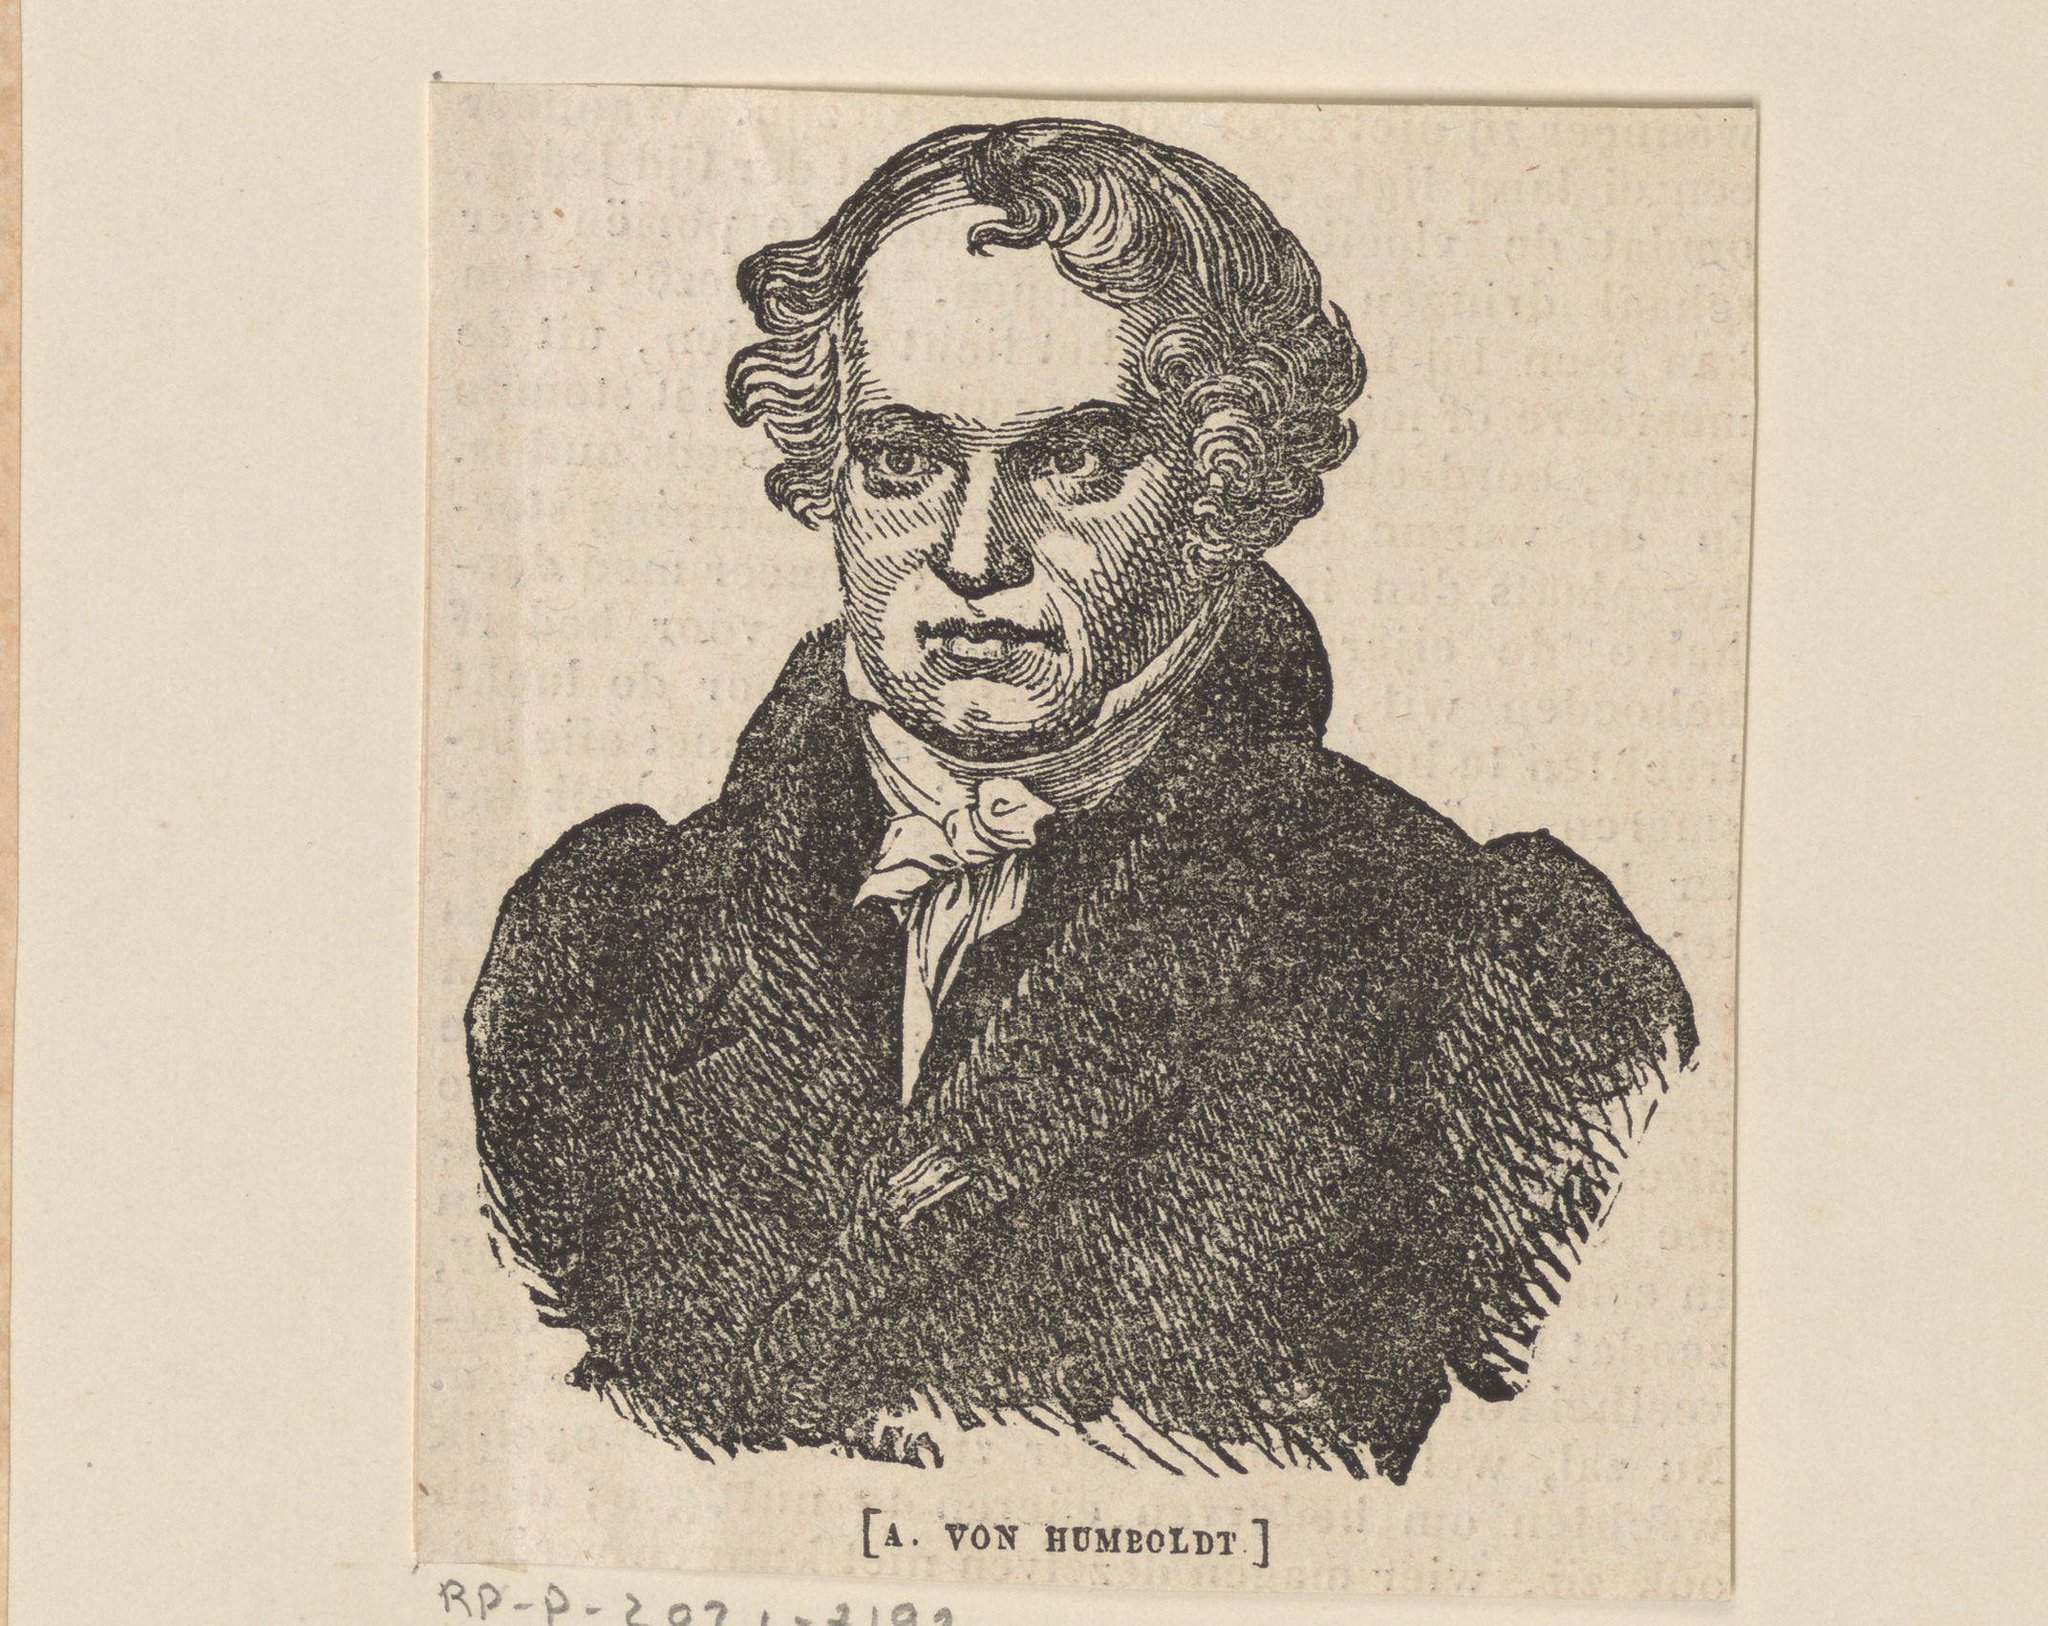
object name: print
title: Portret van Alexander von Humboldt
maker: Anonymous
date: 1836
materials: paper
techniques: letterpress printing, engraving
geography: amsterdam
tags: berlin, traveler, historical persons, biology (+ portrait of scholar, scientist)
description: Prent uit: Nederlandsch magazijn, ter verspreiding van algemeene en nuttige kundigheden. Amsterdam: gebroeders Diederichs, 1836.